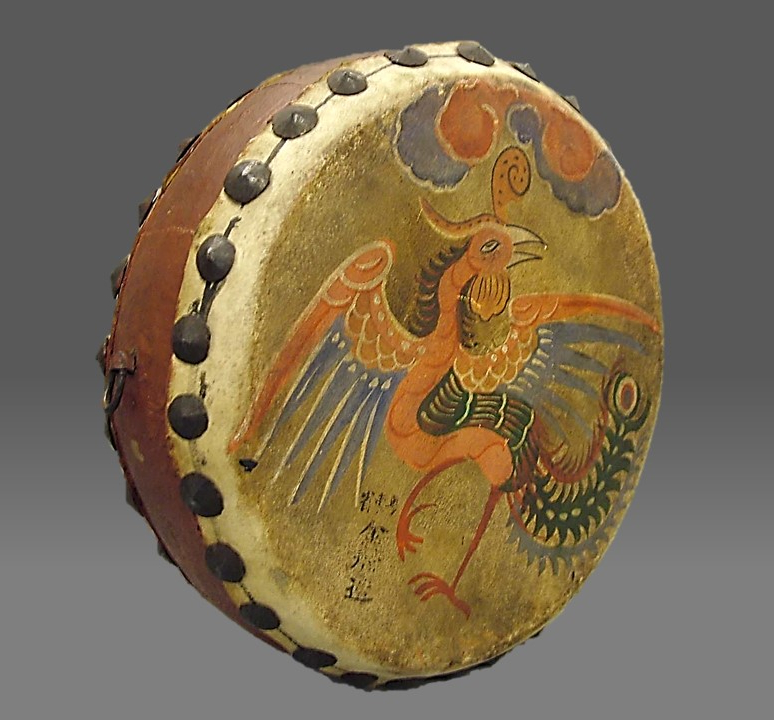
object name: huagu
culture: chinese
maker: chin shing (golden voice) store, canton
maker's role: manufacturer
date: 1801-1900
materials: metal, skin, wood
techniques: polychrome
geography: china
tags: dragons,phoenix